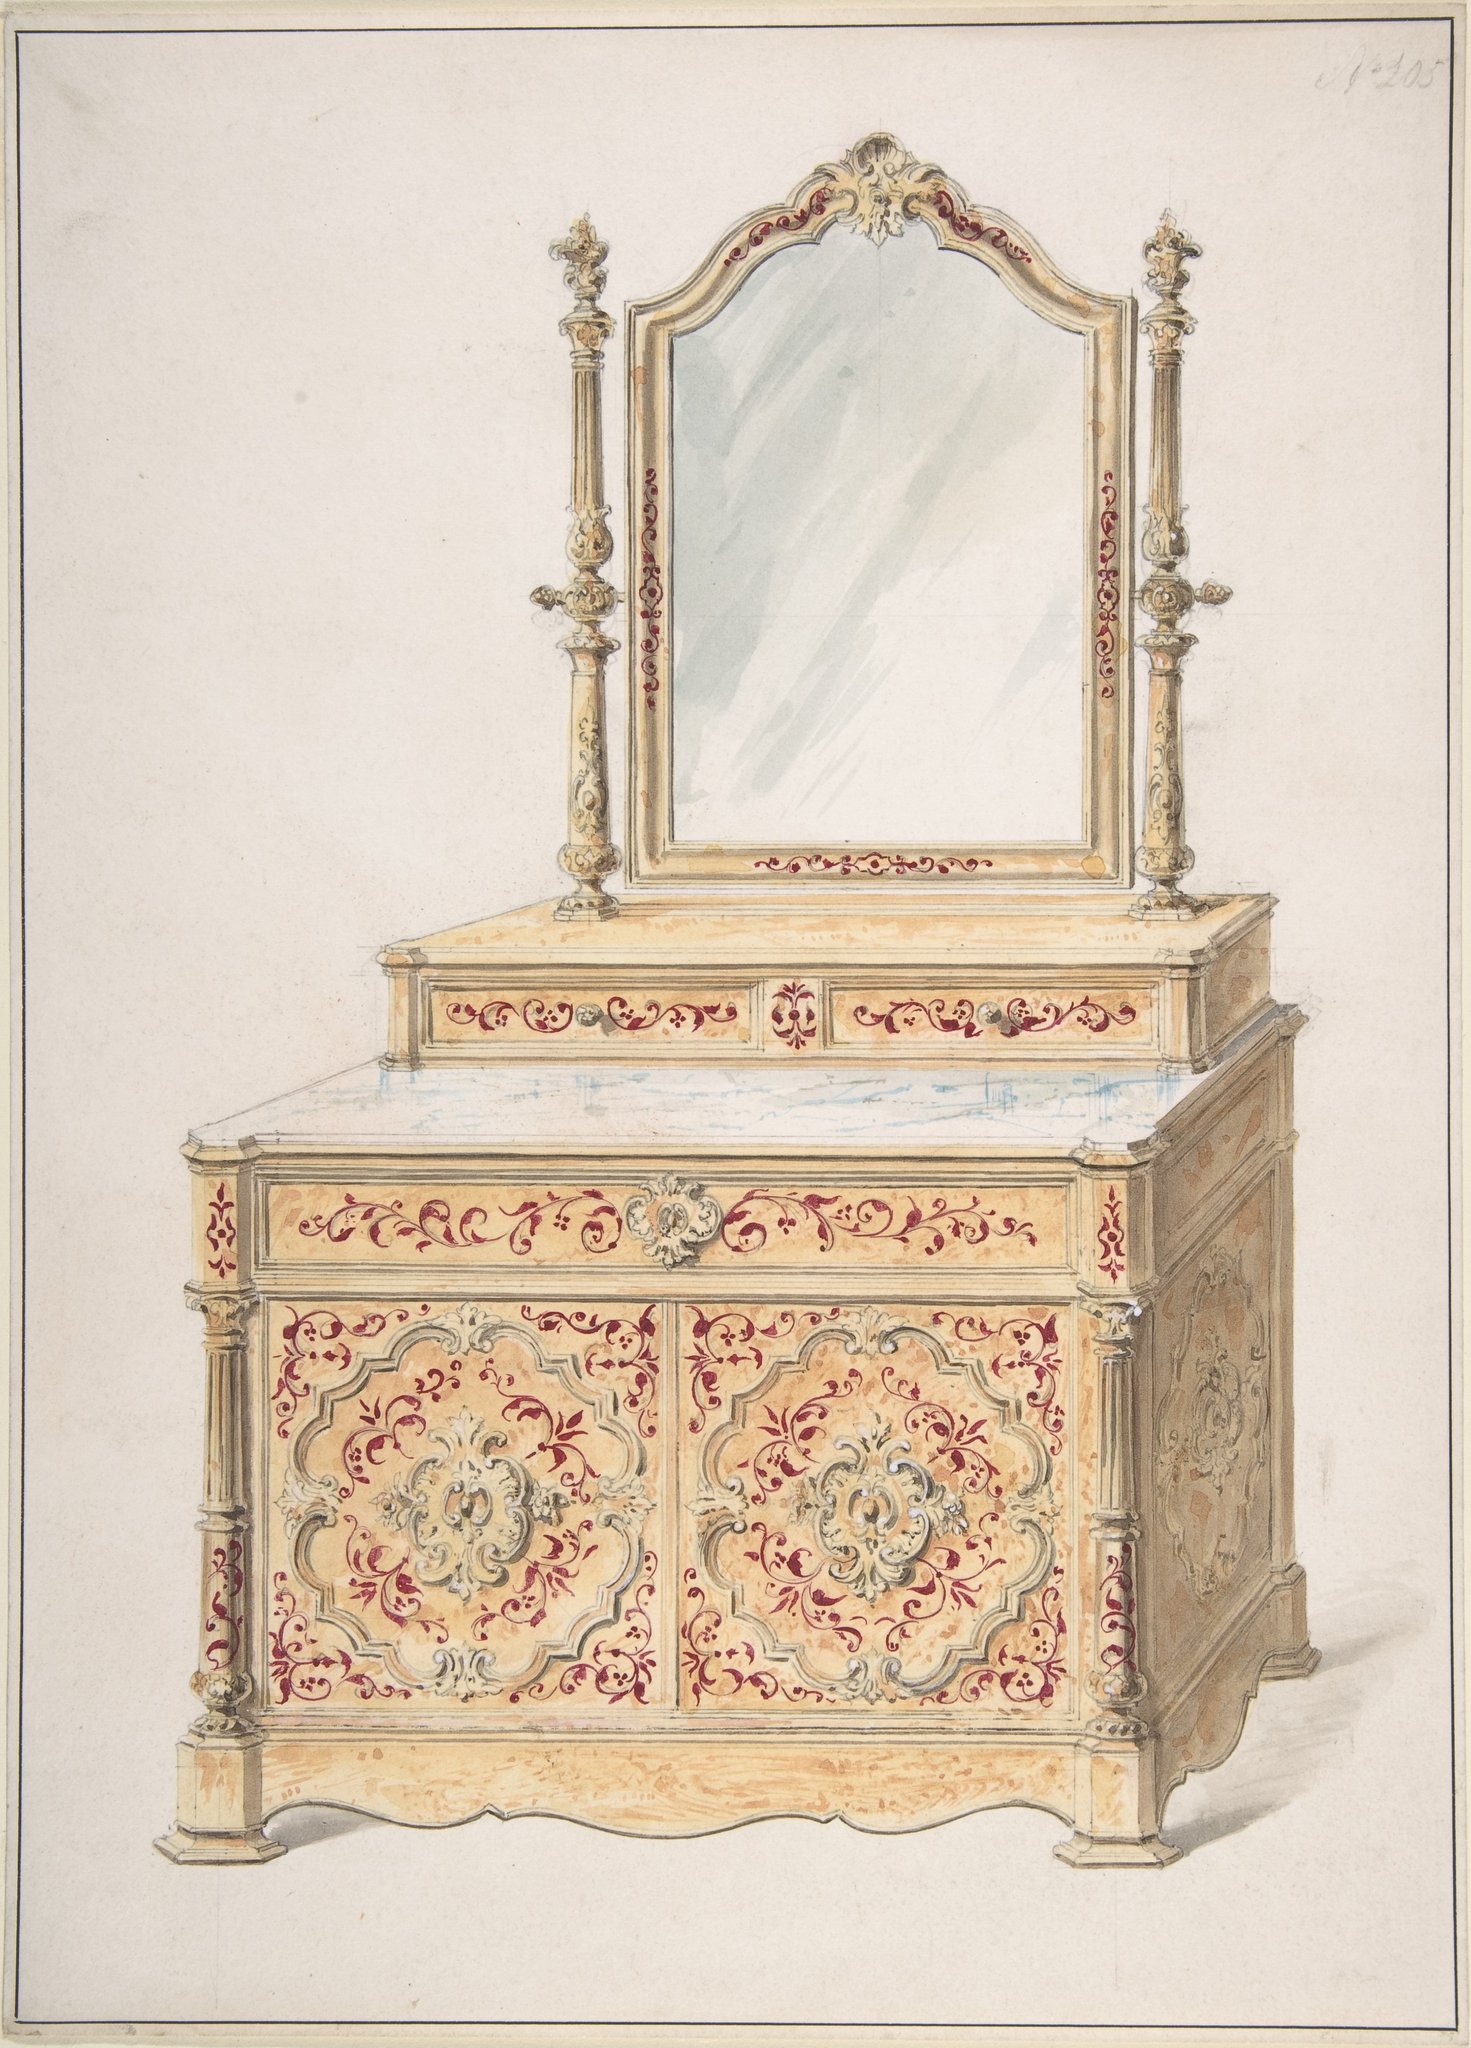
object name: drawing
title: Design for a Marble-topped Cabinet and Mirror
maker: anonymous, british, 19th century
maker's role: artist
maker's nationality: british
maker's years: 1800-1900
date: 1840-1899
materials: ink, watercolor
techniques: brush, pen, wash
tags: cabinets,mirrors